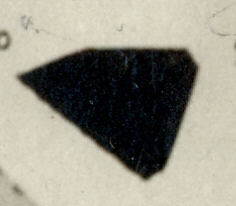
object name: fragment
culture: european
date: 1101-1500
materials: glass